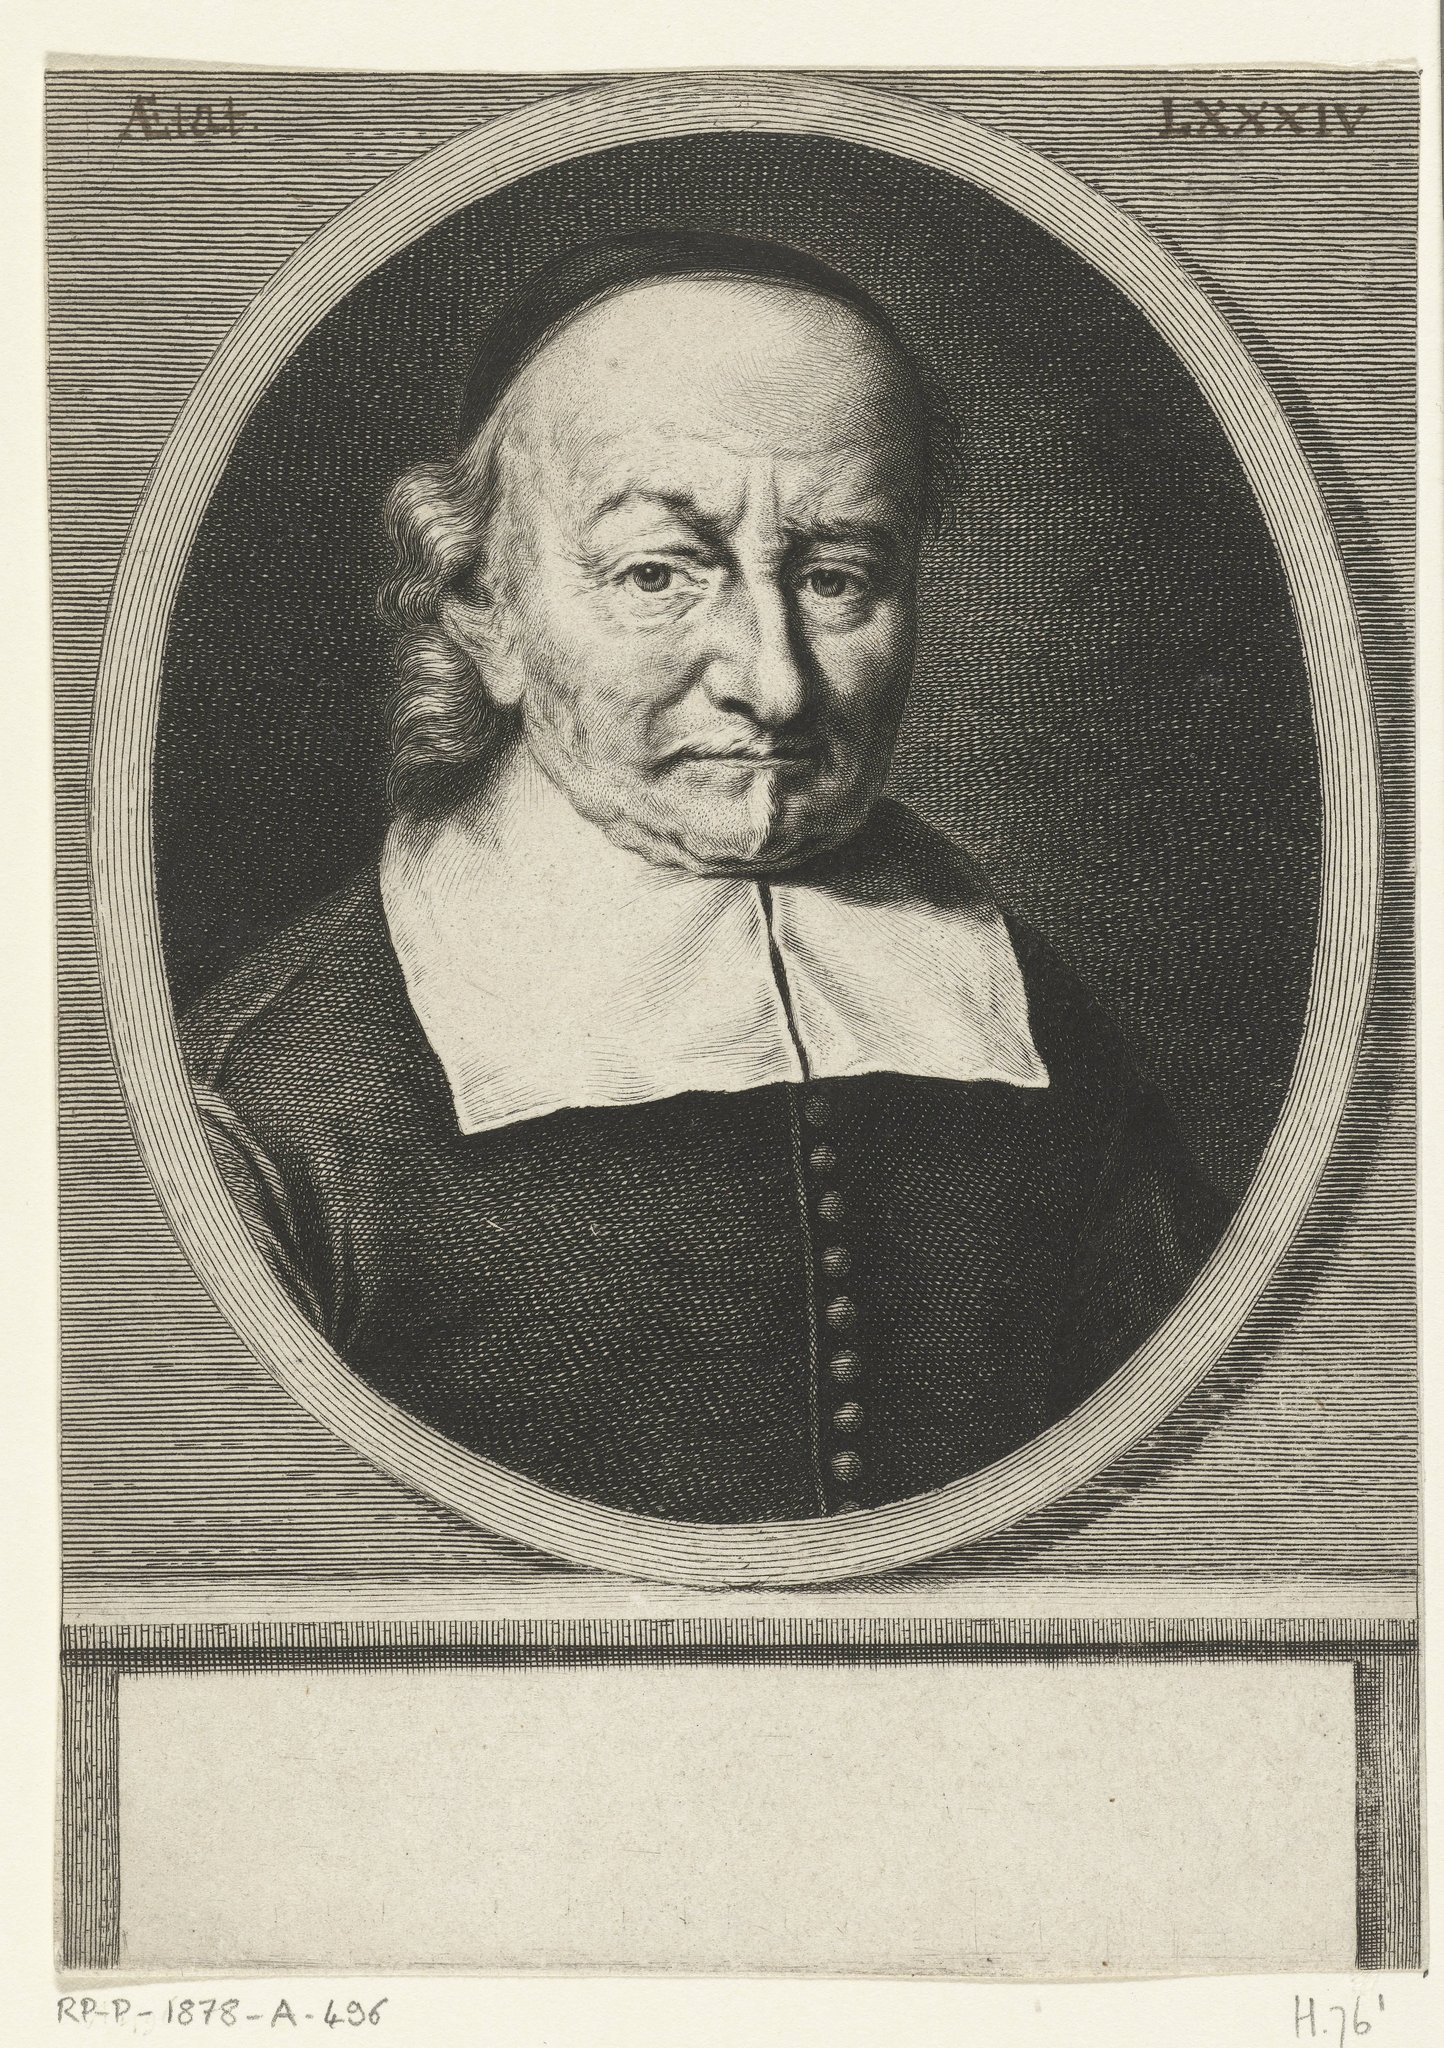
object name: print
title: Portret van Joost van den Vondel op 84-jarige leeftijd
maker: hendrik bary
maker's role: draughtsman, print maker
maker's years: 1640-1707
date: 1657-1707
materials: paper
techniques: engraving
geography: netherlands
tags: cologne, amsterdam, joost van den vondel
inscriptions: inscription: ‘Aetat. LXXXIV’, collector's mark: Lugt 2228